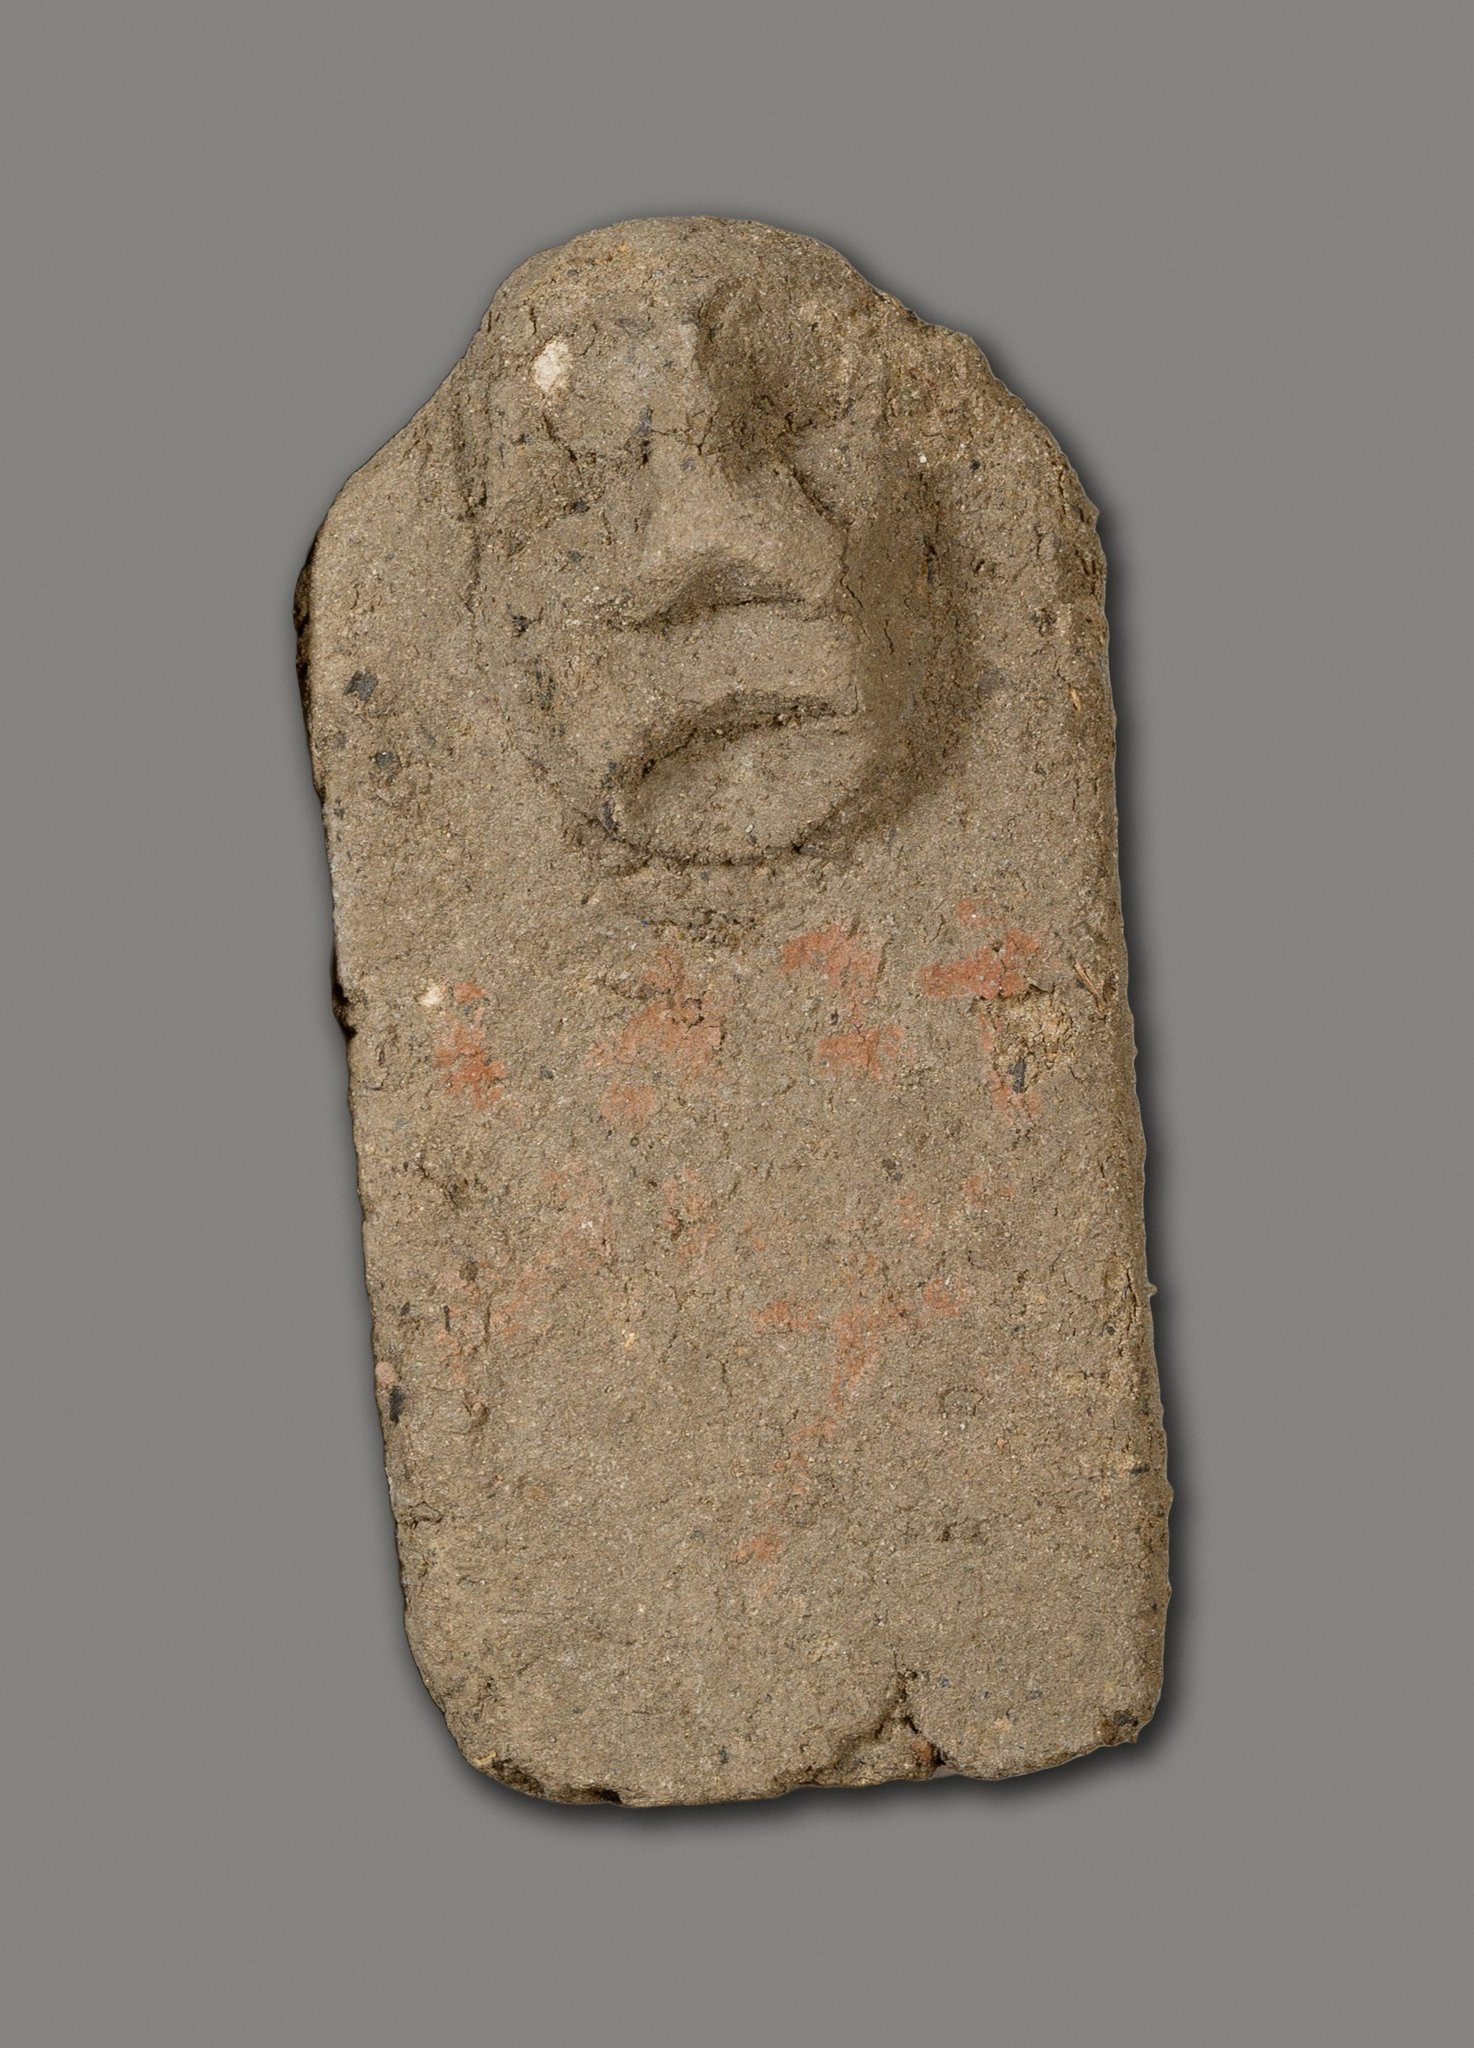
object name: figure, magical, execration, tablet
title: Magical Figure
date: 1802-1550 BCE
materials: clay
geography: egypt